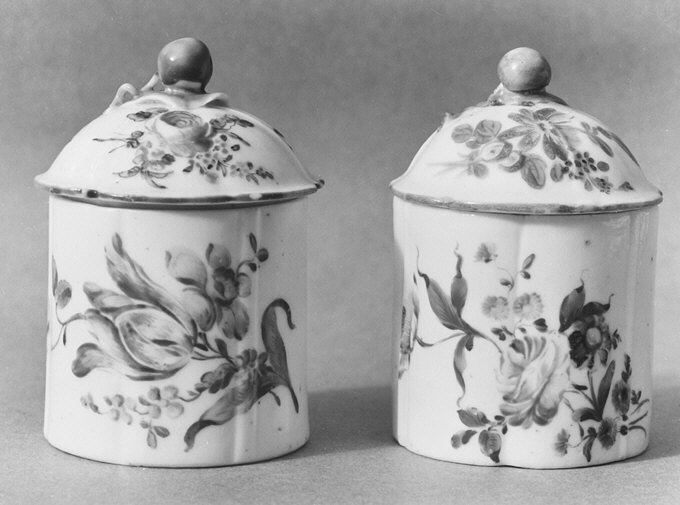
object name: pomade jar with cover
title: Pair of pomade jars with covers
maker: mennecy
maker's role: factory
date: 1750-1760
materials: soft paste porcelain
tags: flowers